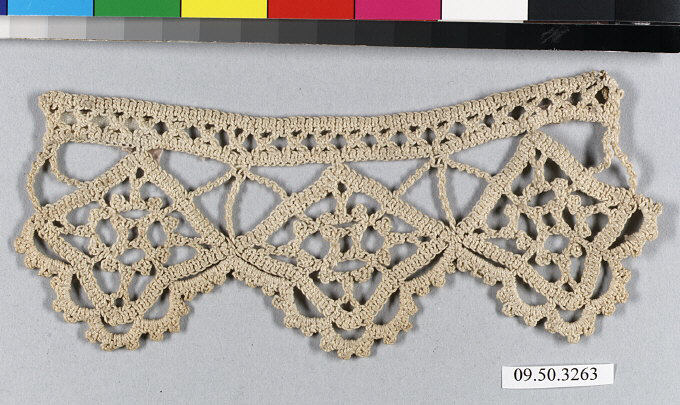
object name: sample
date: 1801-1900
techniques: crochet